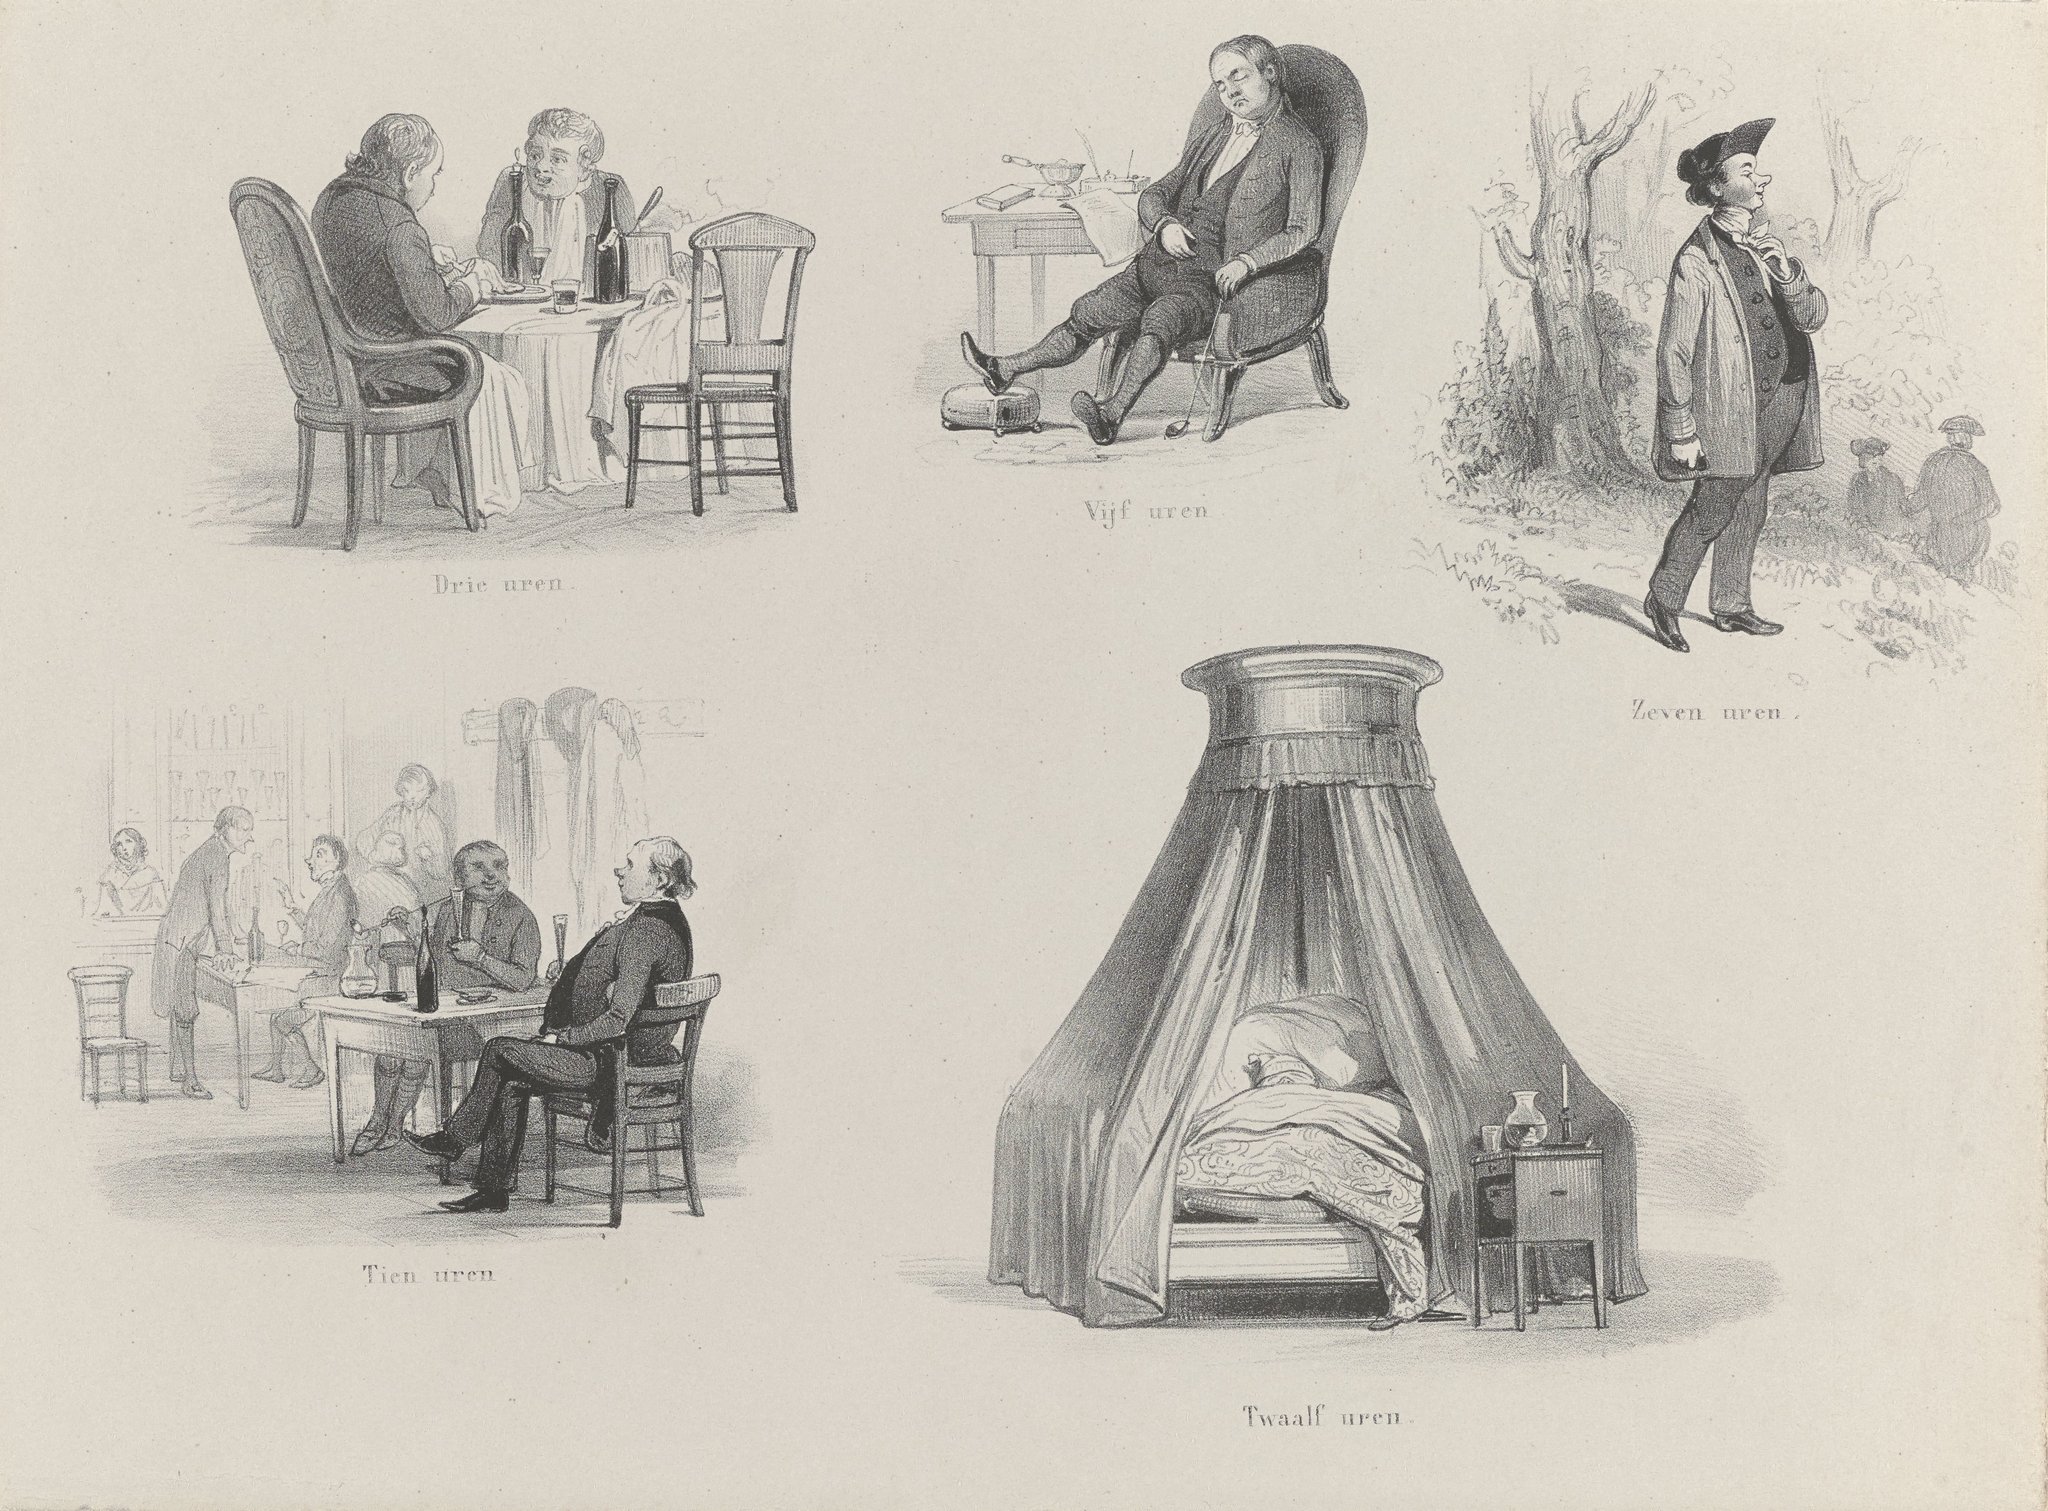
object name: print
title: Handelingen der Herv: Sijnode 1849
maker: Anonymous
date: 1849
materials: paper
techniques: lithograph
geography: zaltbommel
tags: organizations, assemblies, etc. in protestant churches, amsterdam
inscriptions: collector's mark: Lugt 2228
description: Spotprent op de werkzaamheden van de gedelegeerden op de synode tussen drie uur 's middags en twaalf uur 's avonds. Eten, rusten, wandelen, borrelen, slapen. Losse prent in de omslag met twee andere spotprenten en een tekstblad over de vergadering van de Algemene Synode van de Hervormde Kerk te Amsterdam op 4 juli 1849.